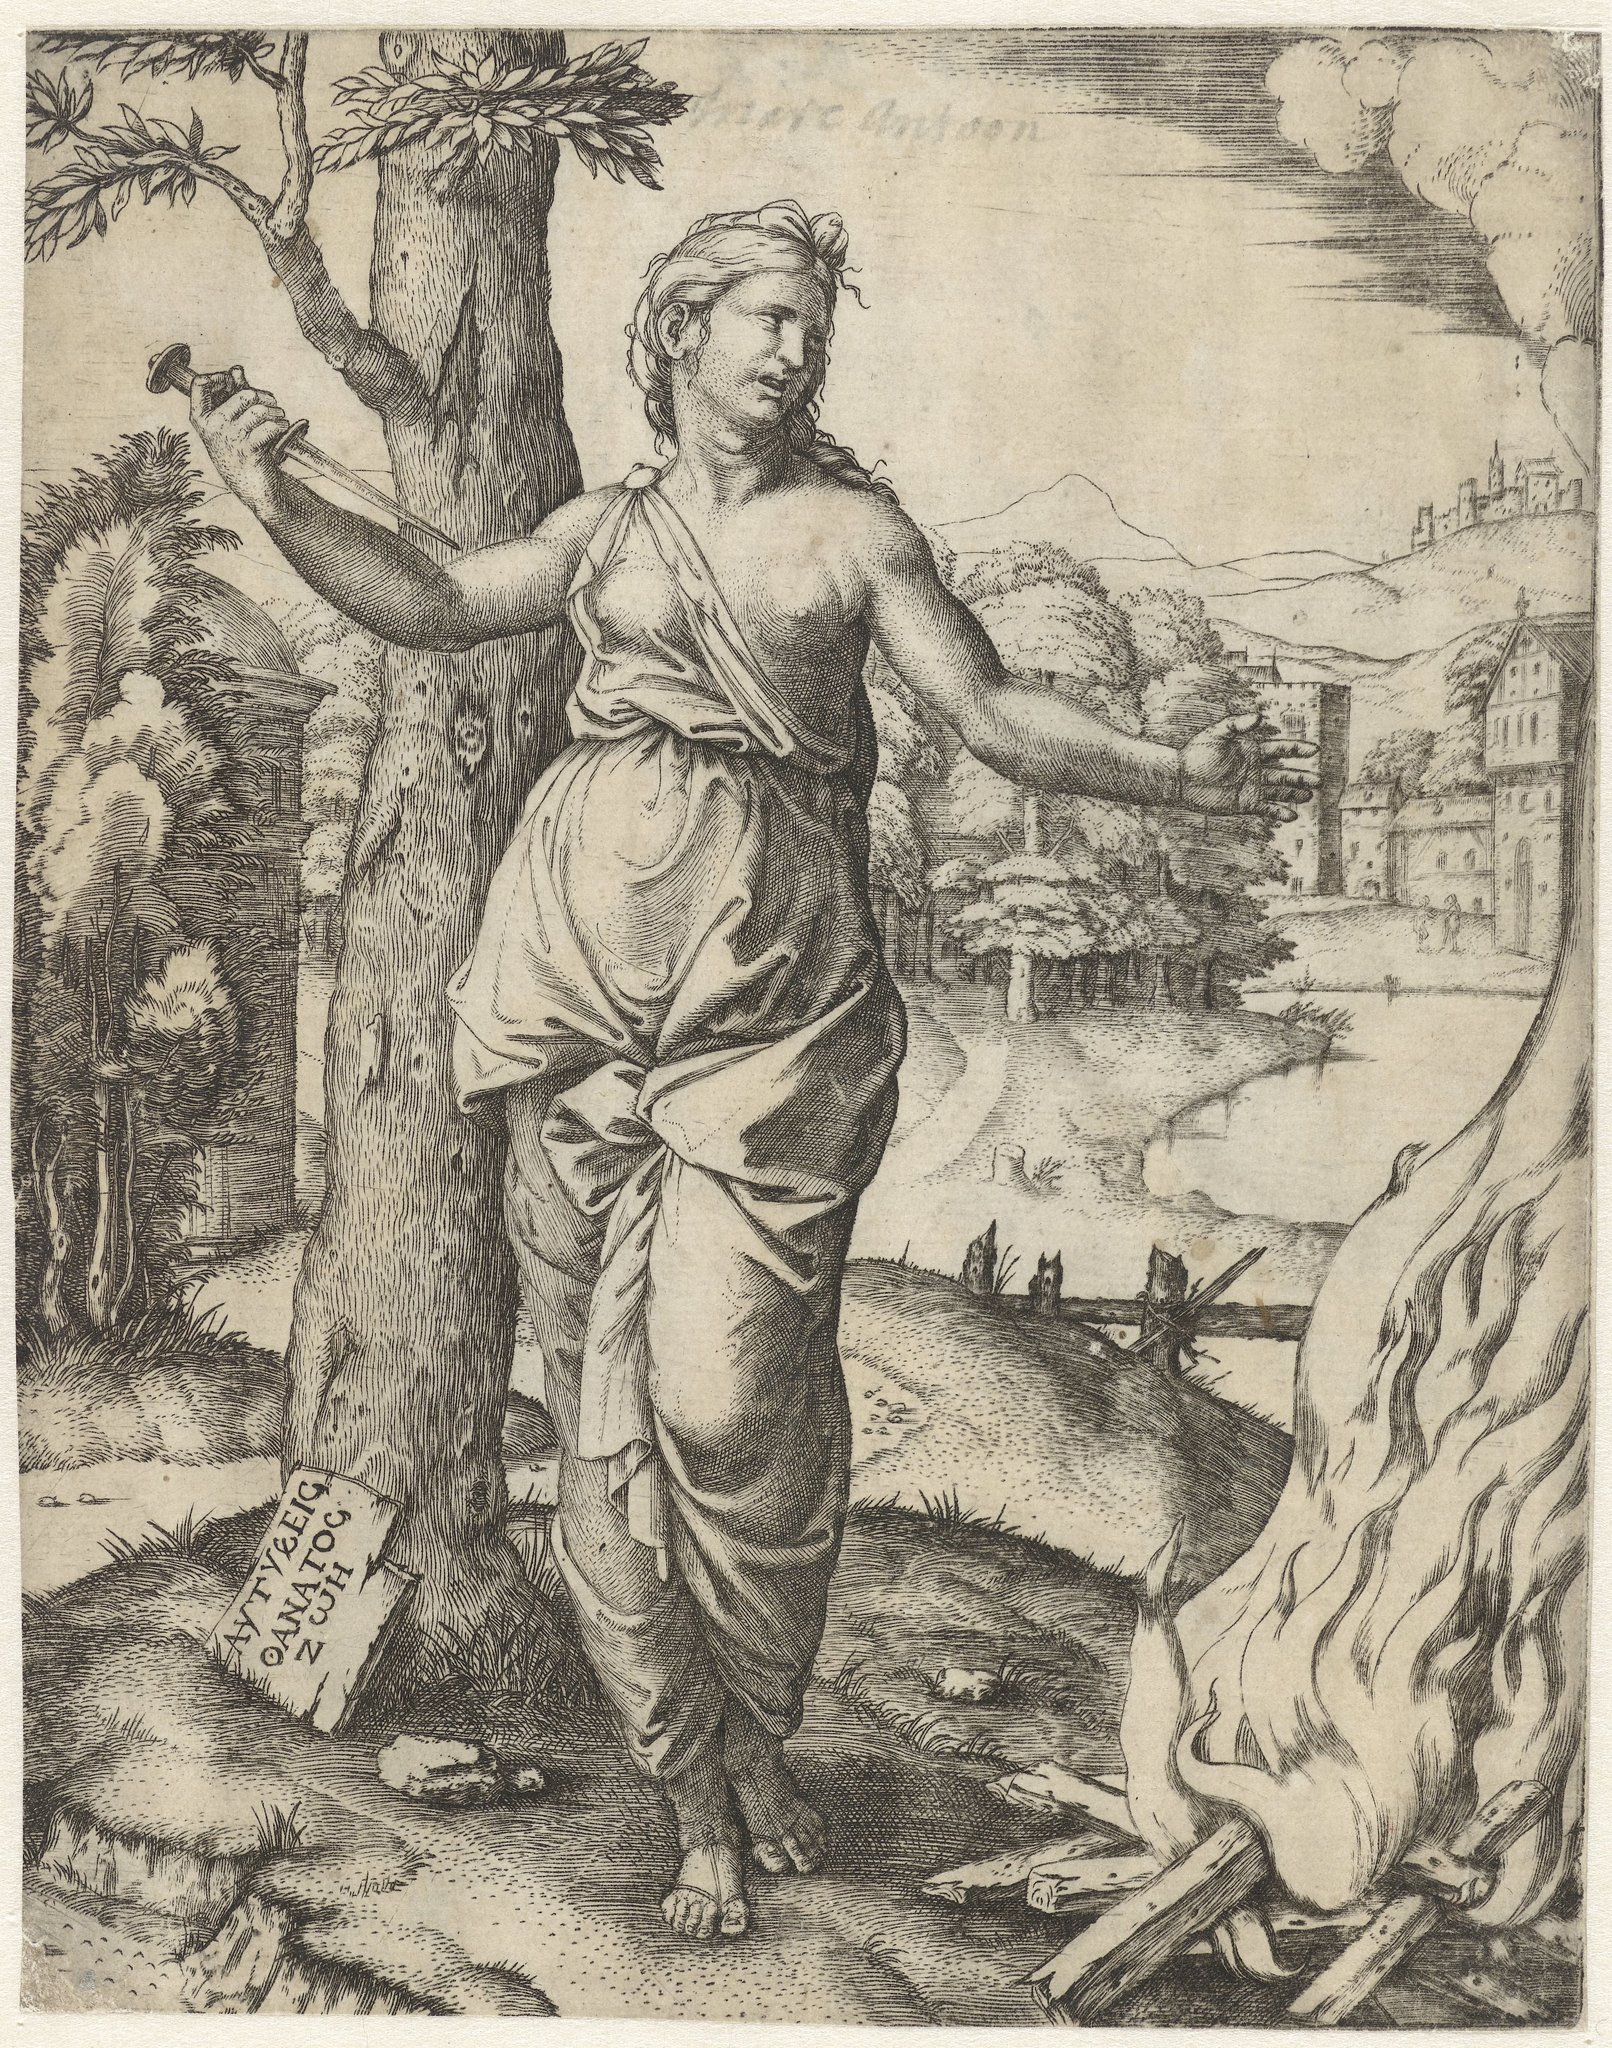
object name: print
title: Dido doodt zichzelf met dolk naast brandstapel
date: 1508-1512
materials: paper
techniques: engraving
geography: italy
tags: (story of) dido, death of dido; she climbs the funeral pyre and falls upon the sword of aeneas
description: De figuur van de heilige lijkt stilistisch op de fresco's in de Stanza della Segnatura van Raphael te Rome. De tweede staat is herkenbaar aan de griekse tekst op het bordje aan de voet van de boom.